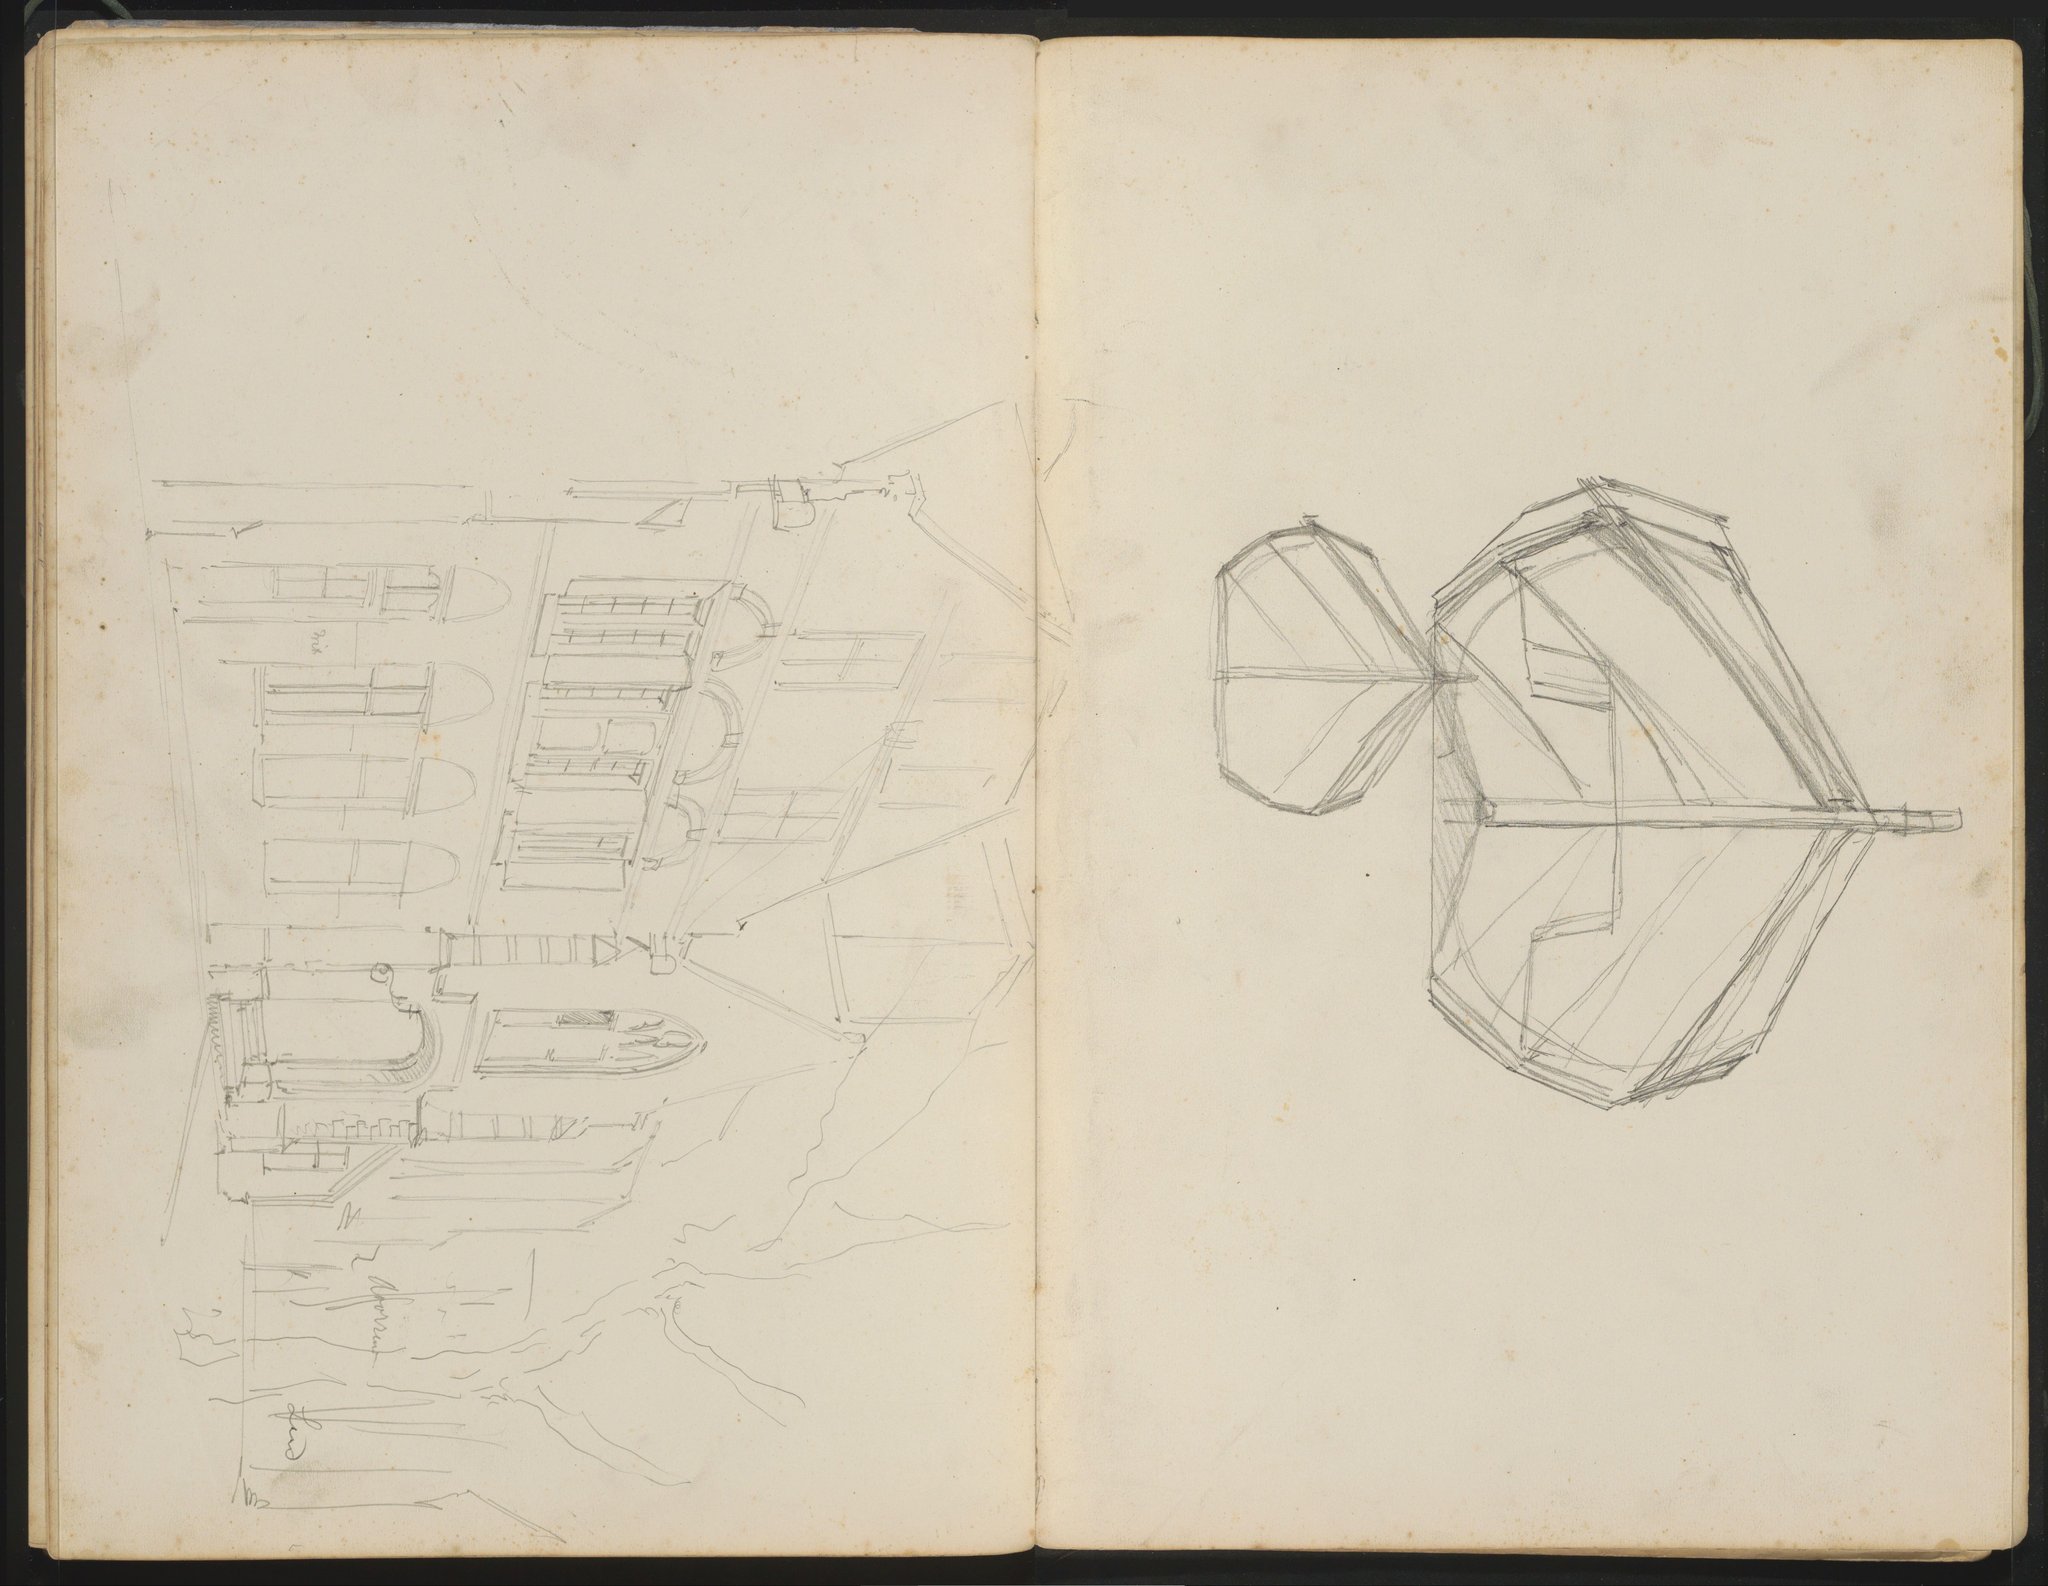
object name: sketchbook leaf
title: Zeilboten en een straatgezicht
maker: willem koekkoek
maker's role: draughtsman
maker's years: 1839-1895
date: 1849-1895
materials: paper, pencil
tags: sailing-ship, sailing-boat, street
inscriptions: kleurnotitie, handgeschreven in potlood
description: Blad 27 verso en 28 recto uit een schetsboek met 35 bladen.